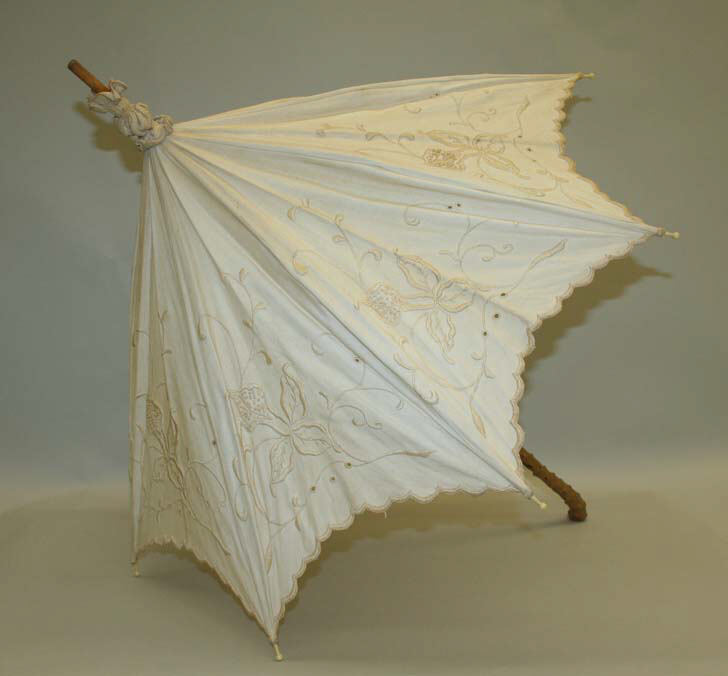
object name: parasol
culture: american or european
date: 1801-1825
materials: linen, wood